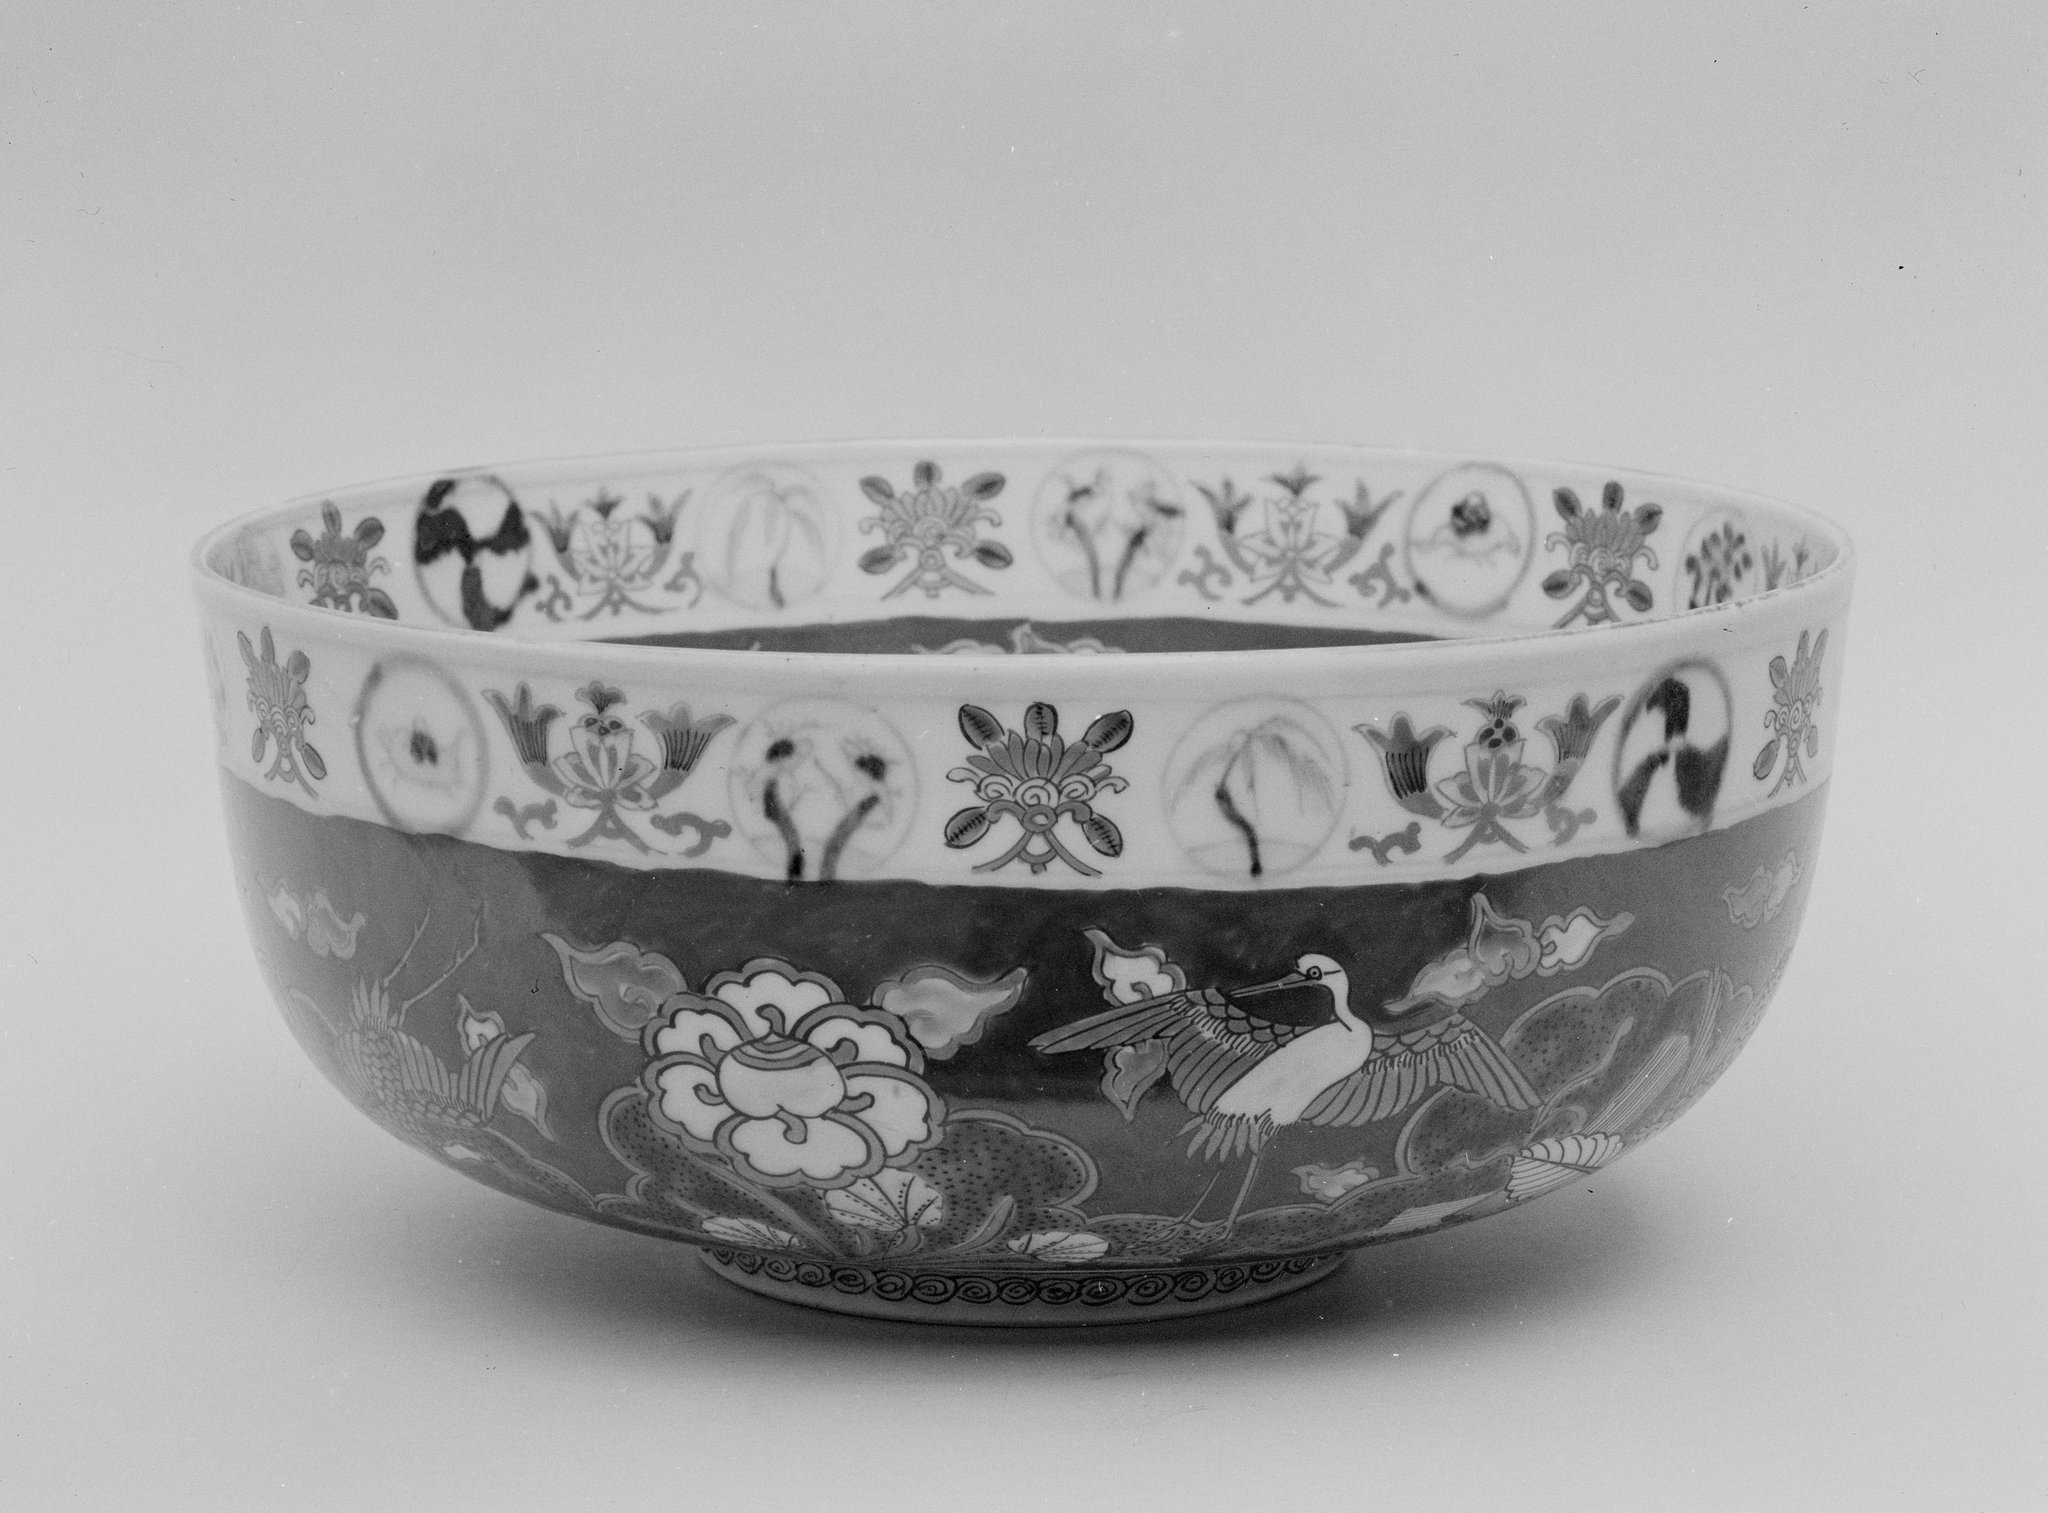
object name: bowl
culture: japanese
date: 1701-1900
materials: gilt, porcelain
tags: birds,flowers